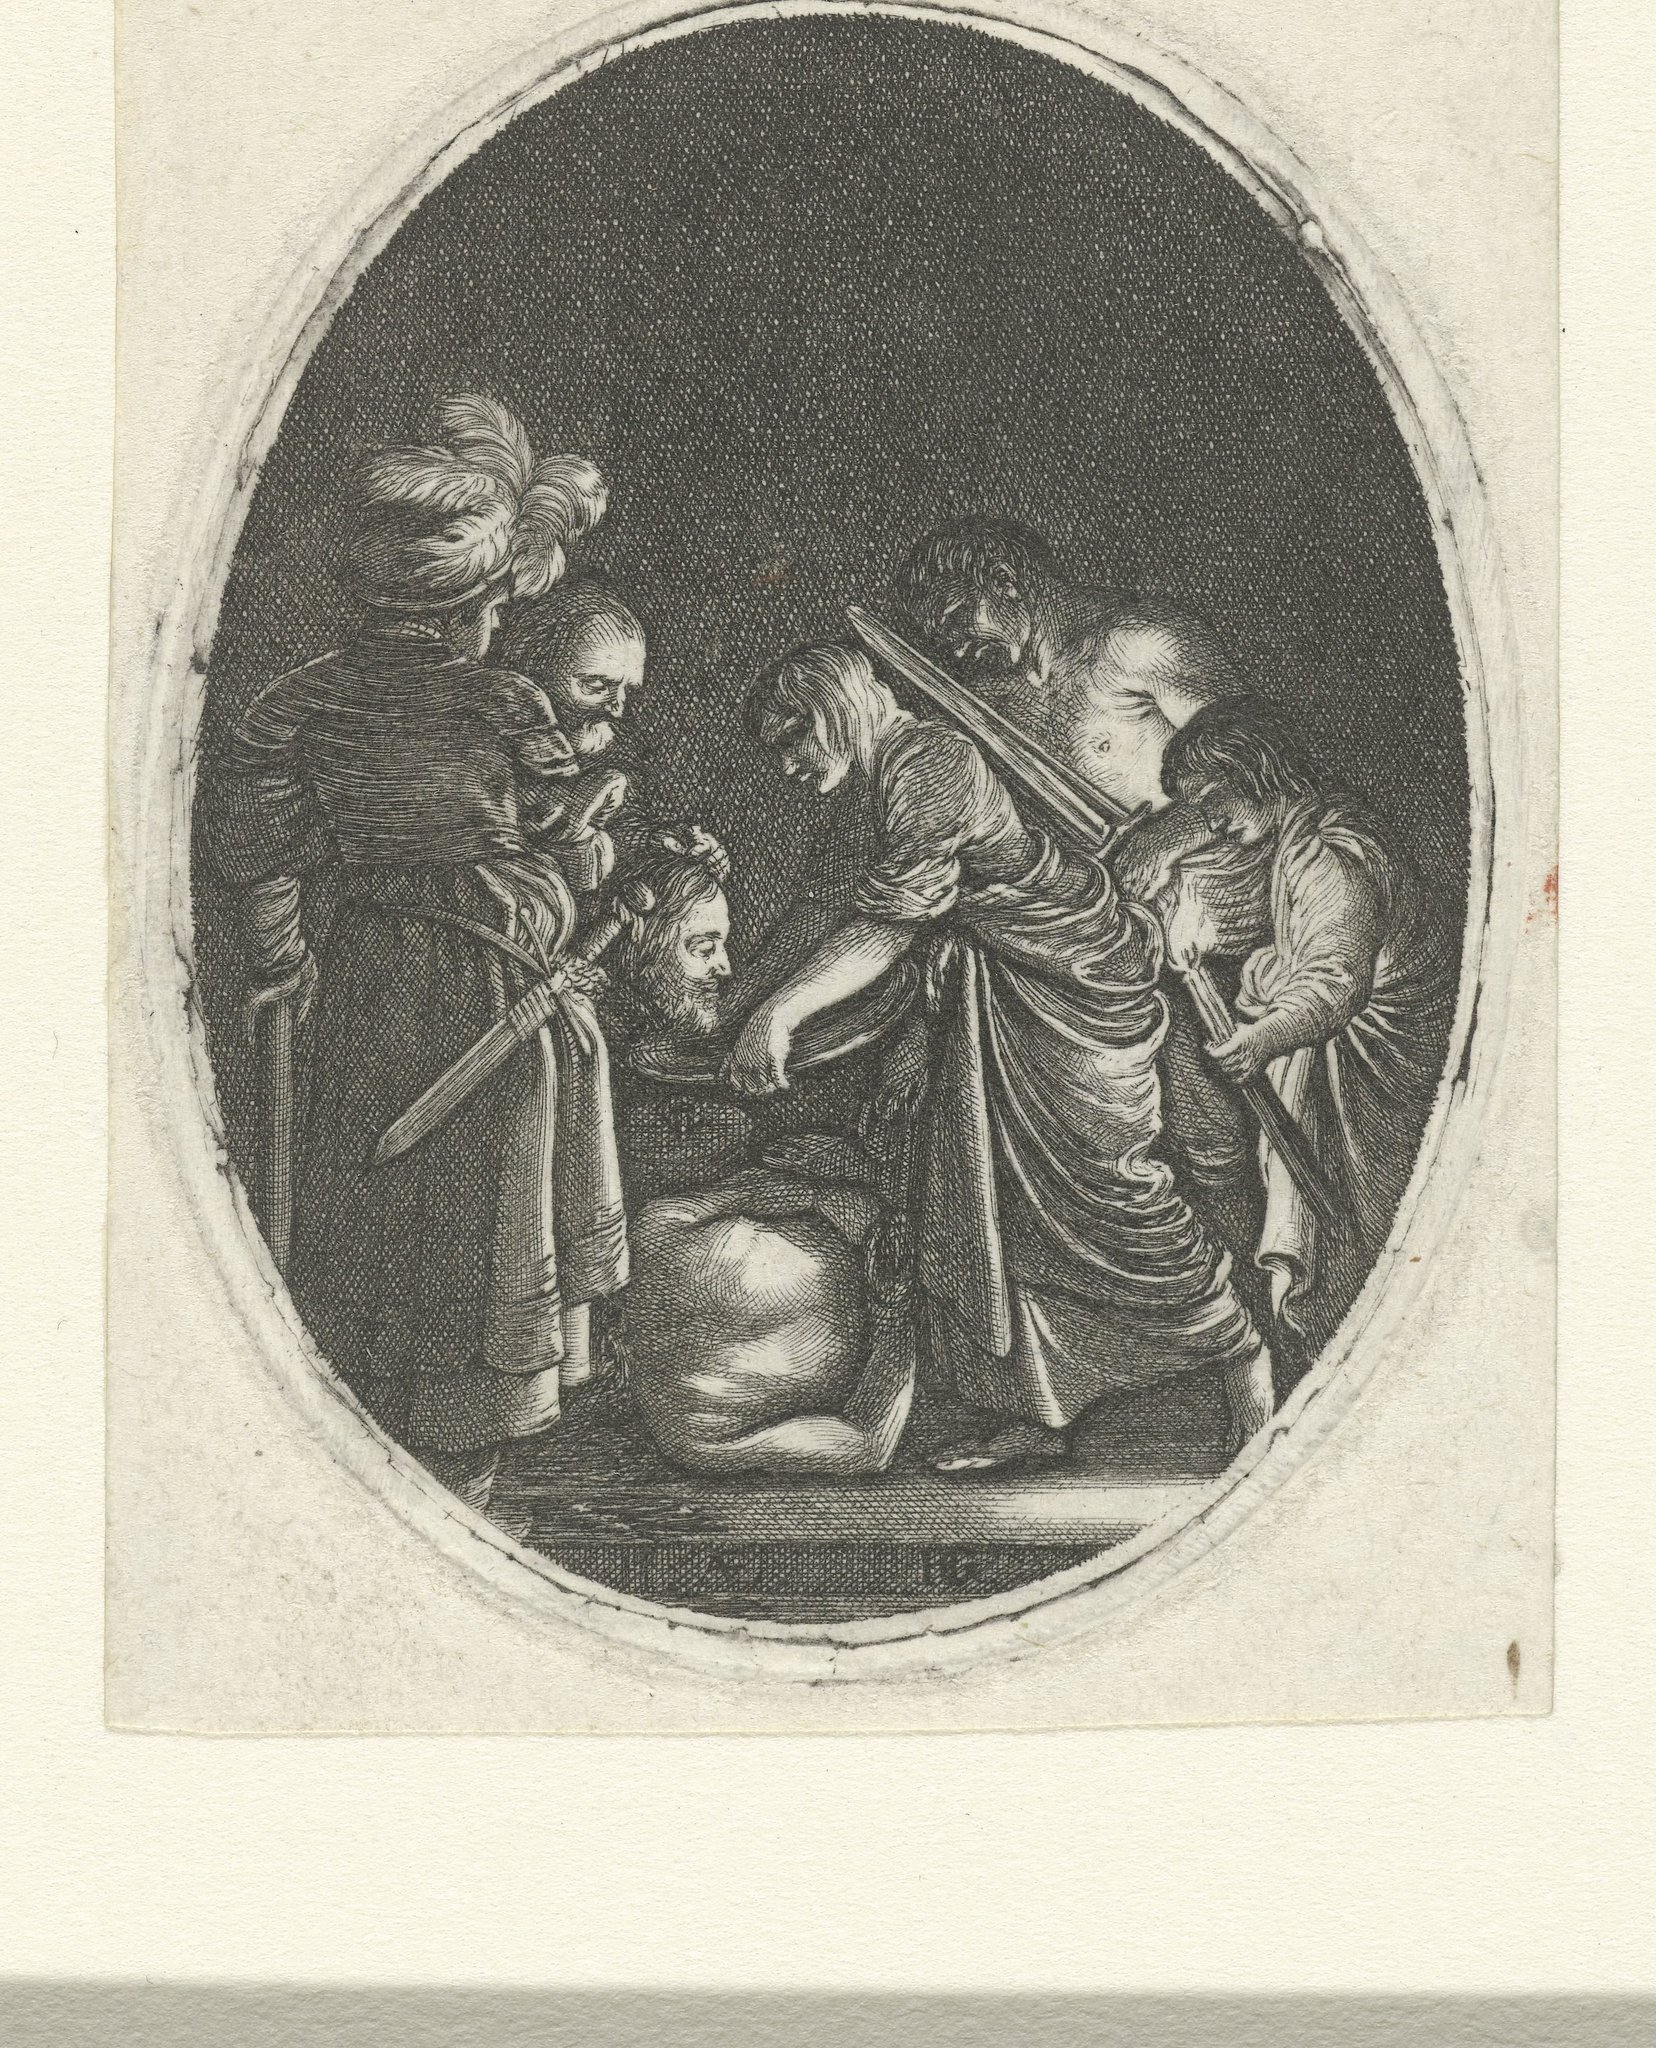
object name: print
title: Presentatie van het hoofd van Johannes de Doper aan Salome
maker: hendrick goudt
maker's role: draughtsman, print maker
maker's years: 1581-1648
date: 1591-1648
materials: paper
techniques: engraving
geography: rome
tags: salome is given the head of john the baptist by the executioner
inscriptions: collector's mark: Lugt 11, collector's mark: Lugt 10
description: In een ovale lijst: de beul presenteert het hoofd van Johannes de Doper aan Salome, die een schotel vasthoudt. Naar een schilderij van Adam Elsheimer.